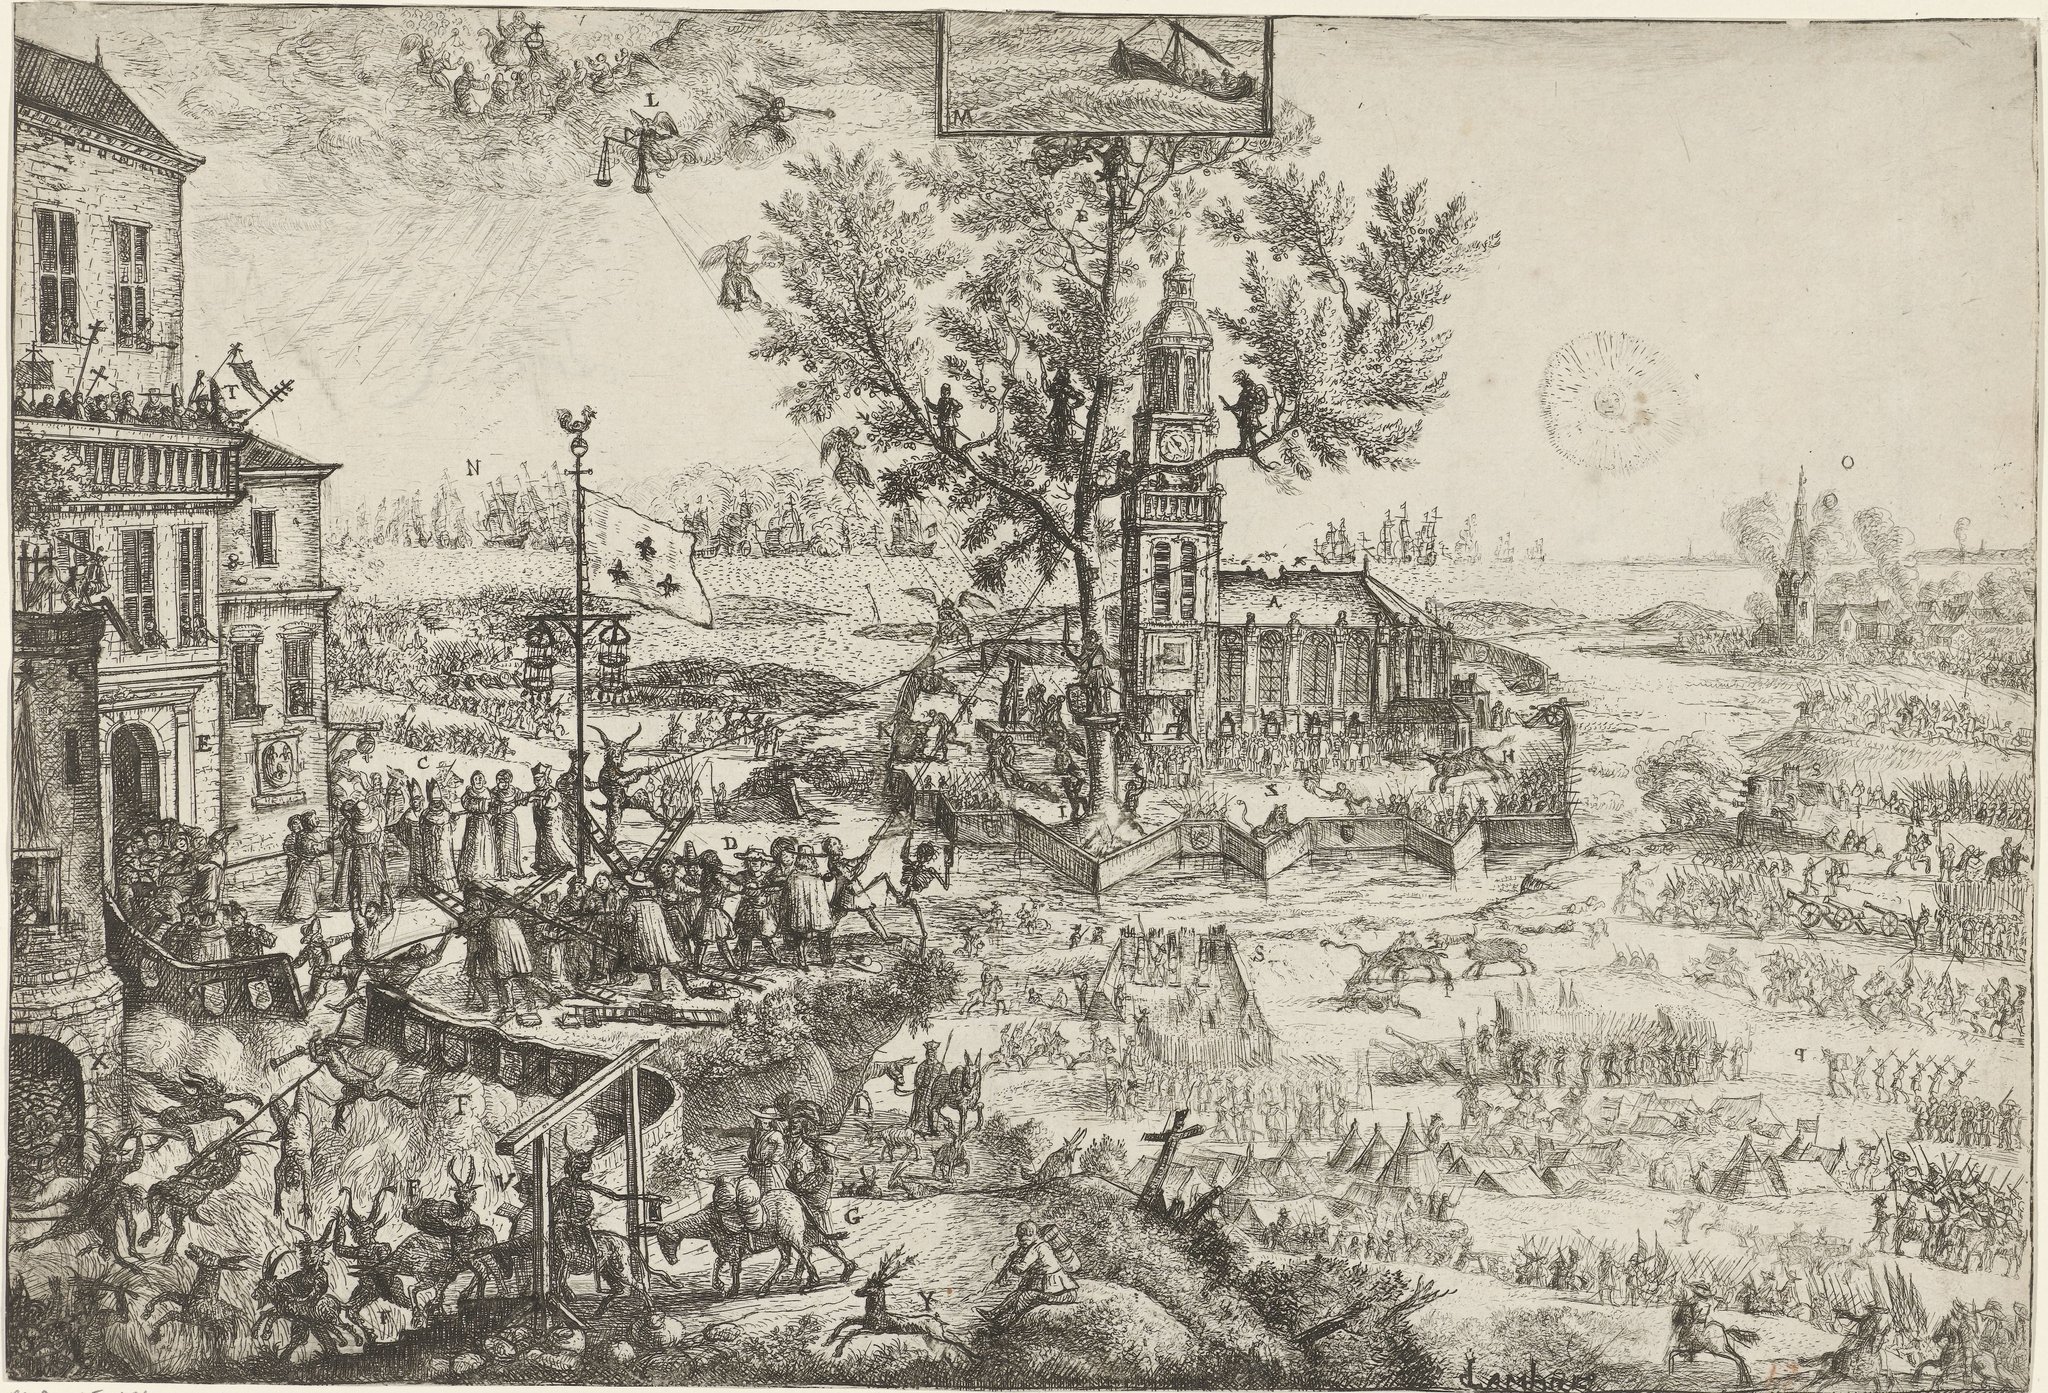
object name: print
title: Aanval op de vesting van Oranje en de Kerk Gods, 1672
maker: jacob de lambre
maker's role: print maker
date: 1672-1674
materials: paper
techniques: drypoint, etching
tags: dordrecht, cornelis de witt, politician, johan de witt, the hague, william iii (prince of orange and king of england, scotland, and ireland), aggression against the church, siege, position war, devil(s) and demons, rampjaar (disaster year)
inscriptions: collector's mark: Lugt 2760, collector's mark: Lugt 2228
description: Aanval op de vesting van Oranje en de Kerk Gods. Uitvoerige allegorische voorstelling van de gebeurtenissen in het jaar 1672. De teneur van de prent is Orangistisch, tegen de Arminianen en de gebroeders de Witt die met vereende krachten (samen met de duivel) proberen de Kerk Gods en de Oranjeboom omver te trekken. Rechts de oprukkende legers, links de gebouwen van het Franse hof en dansende duivels in de hel. De prent is uiteindelijk verschenen met vier kolommen tekst in de marge waarin de verklaring van de voorstelling volgens de letters A-Z en de nummers 1-24 in het Nederlands en Frans staat, gevolgd door een vers in 8 coupletten.